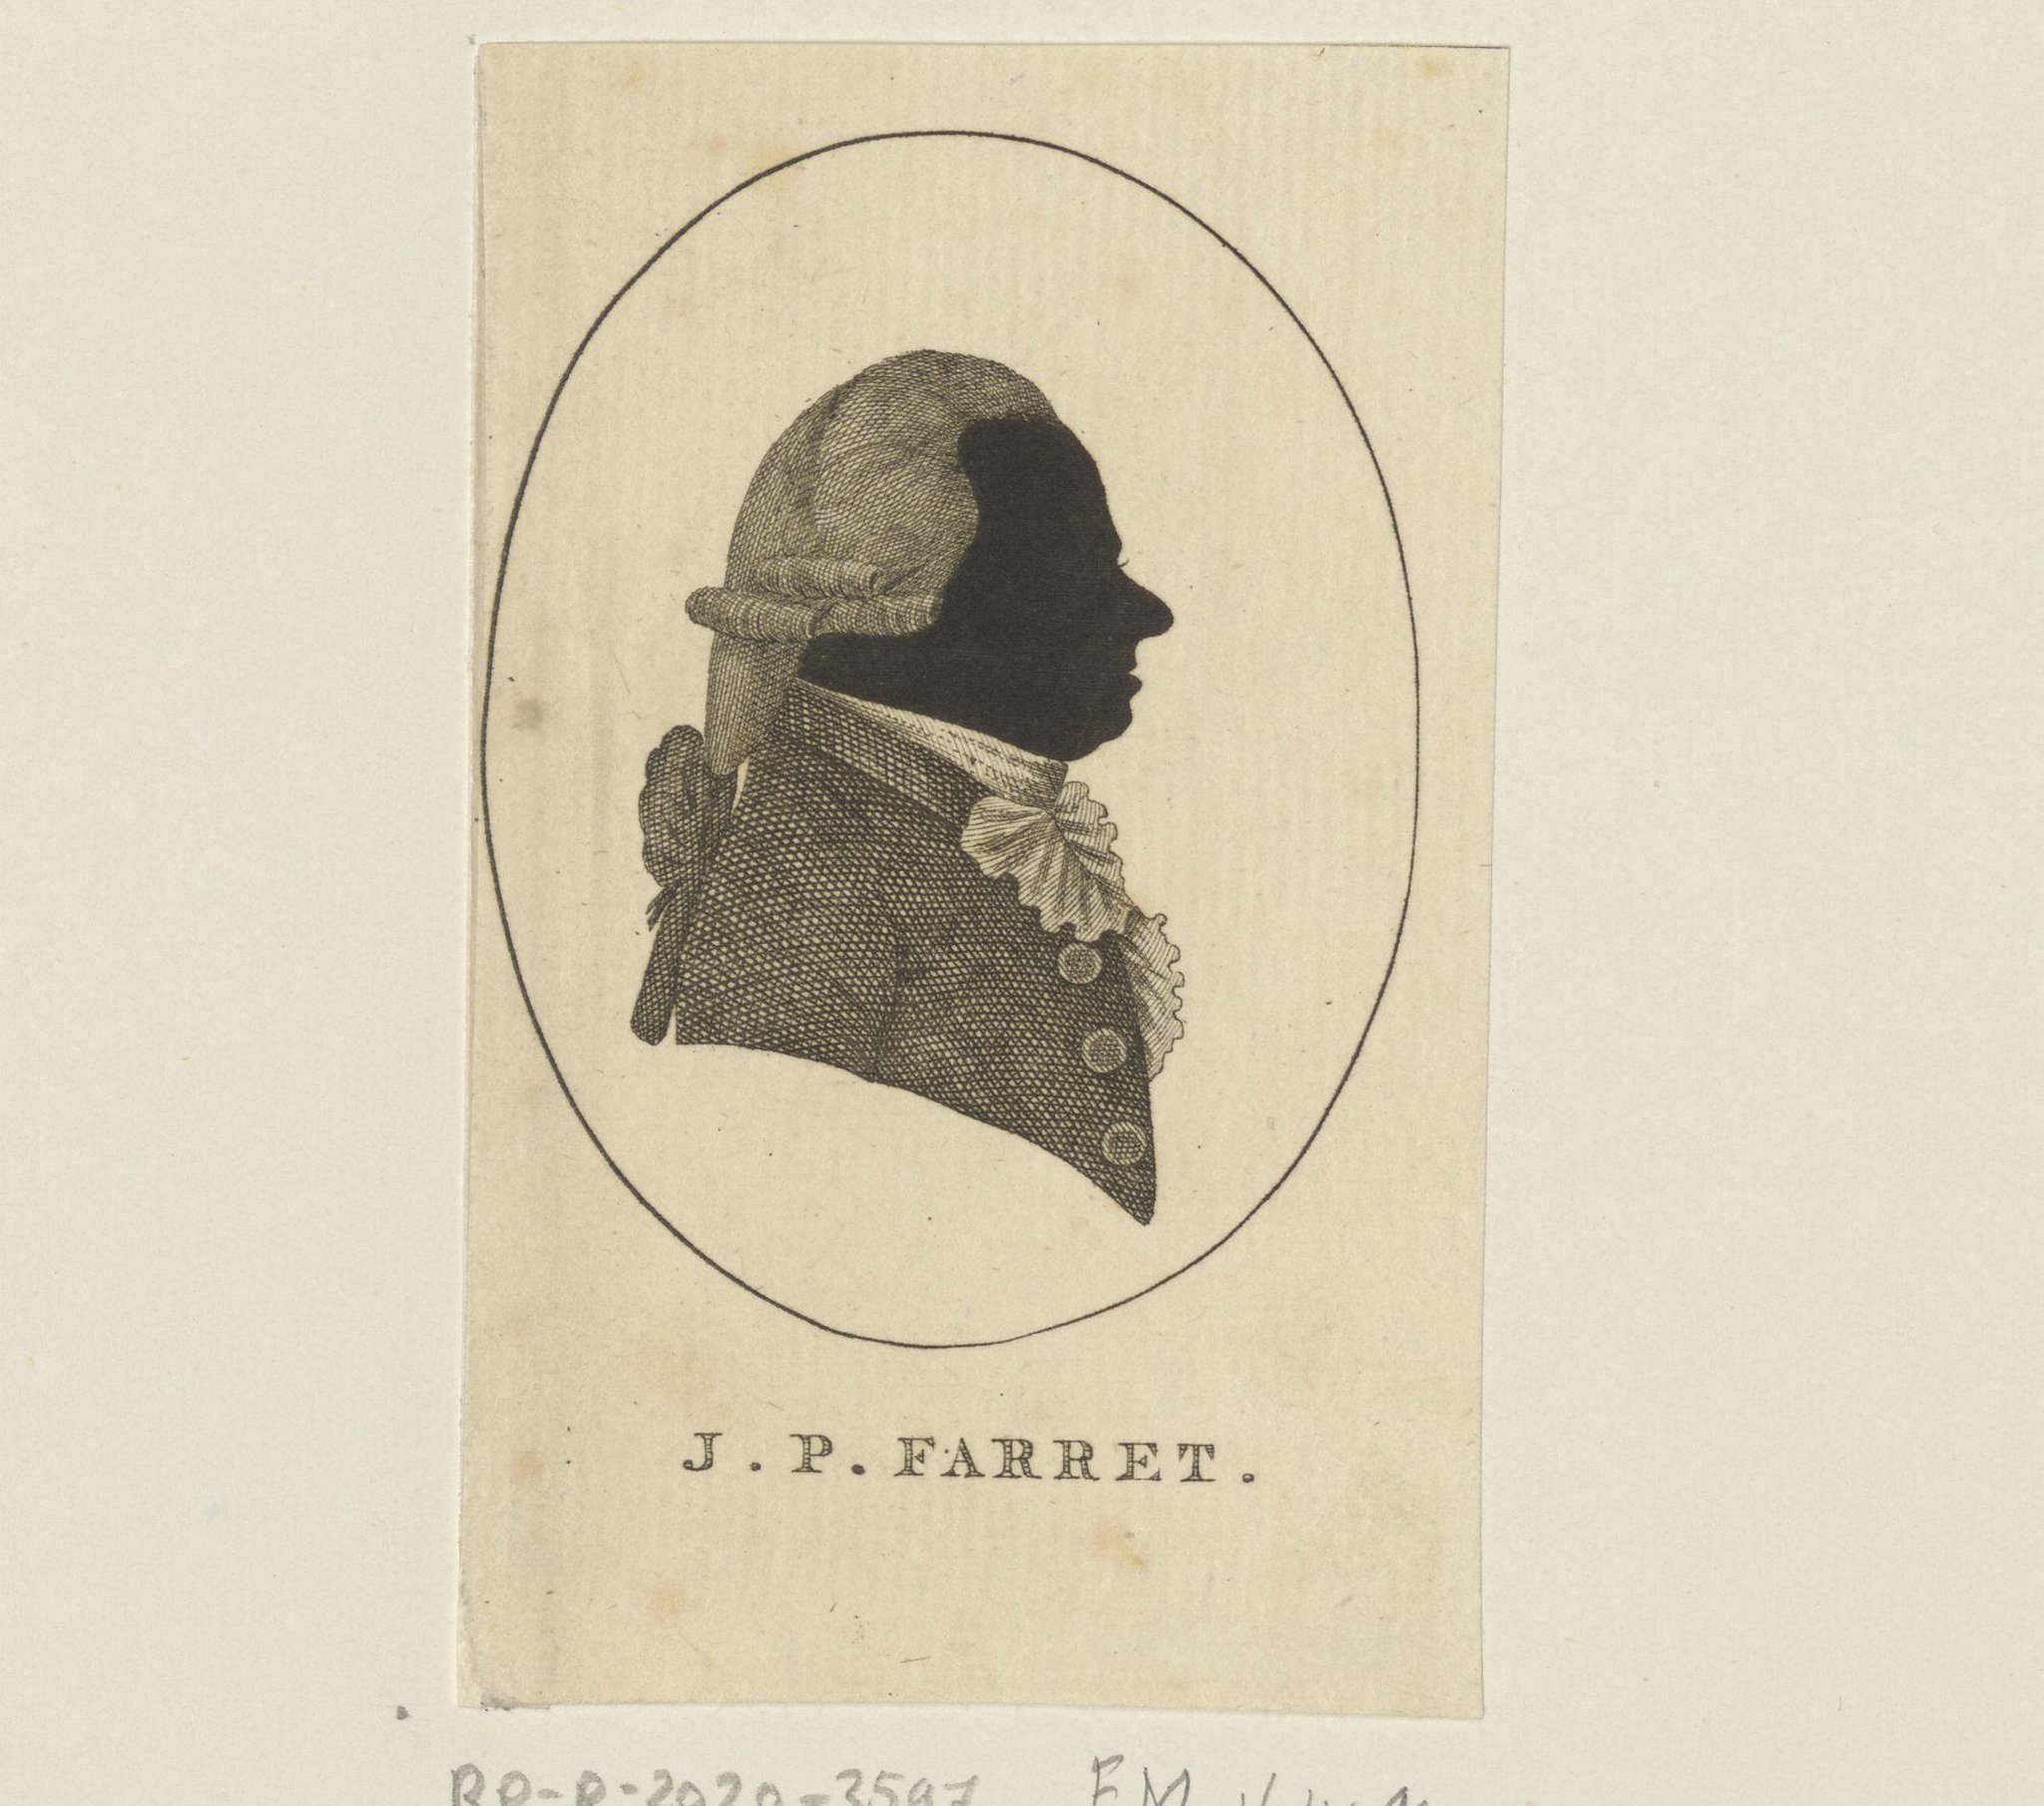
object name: book illustration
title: Silhouetportret van Johan Pieter Farret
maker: Anonymous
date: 1799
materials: paper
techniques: etching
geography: netherlands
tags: amsterdam, historical persons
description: Prent waarschijnlijk uit: Rogge, Cornelius. Geschiedenis der staatsregeling, voor het Bataafsche volk. Amsterdam: Johannes Allart, 1799.